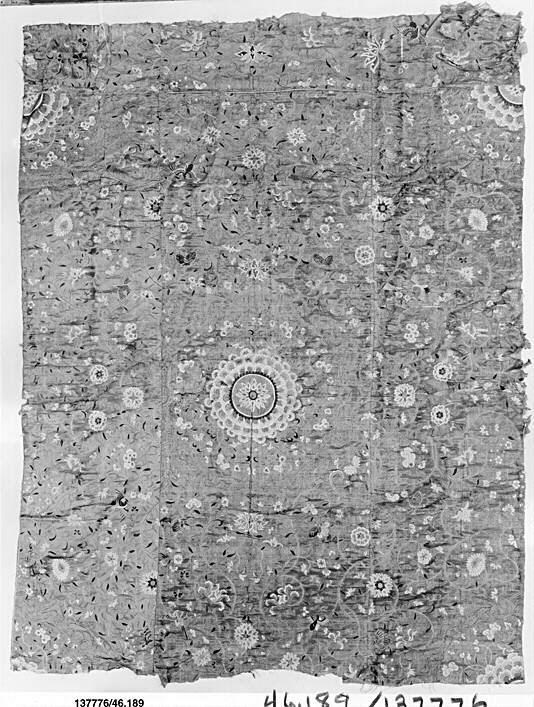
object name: piece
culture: chinese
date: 1601-1800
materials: silk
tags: leaves